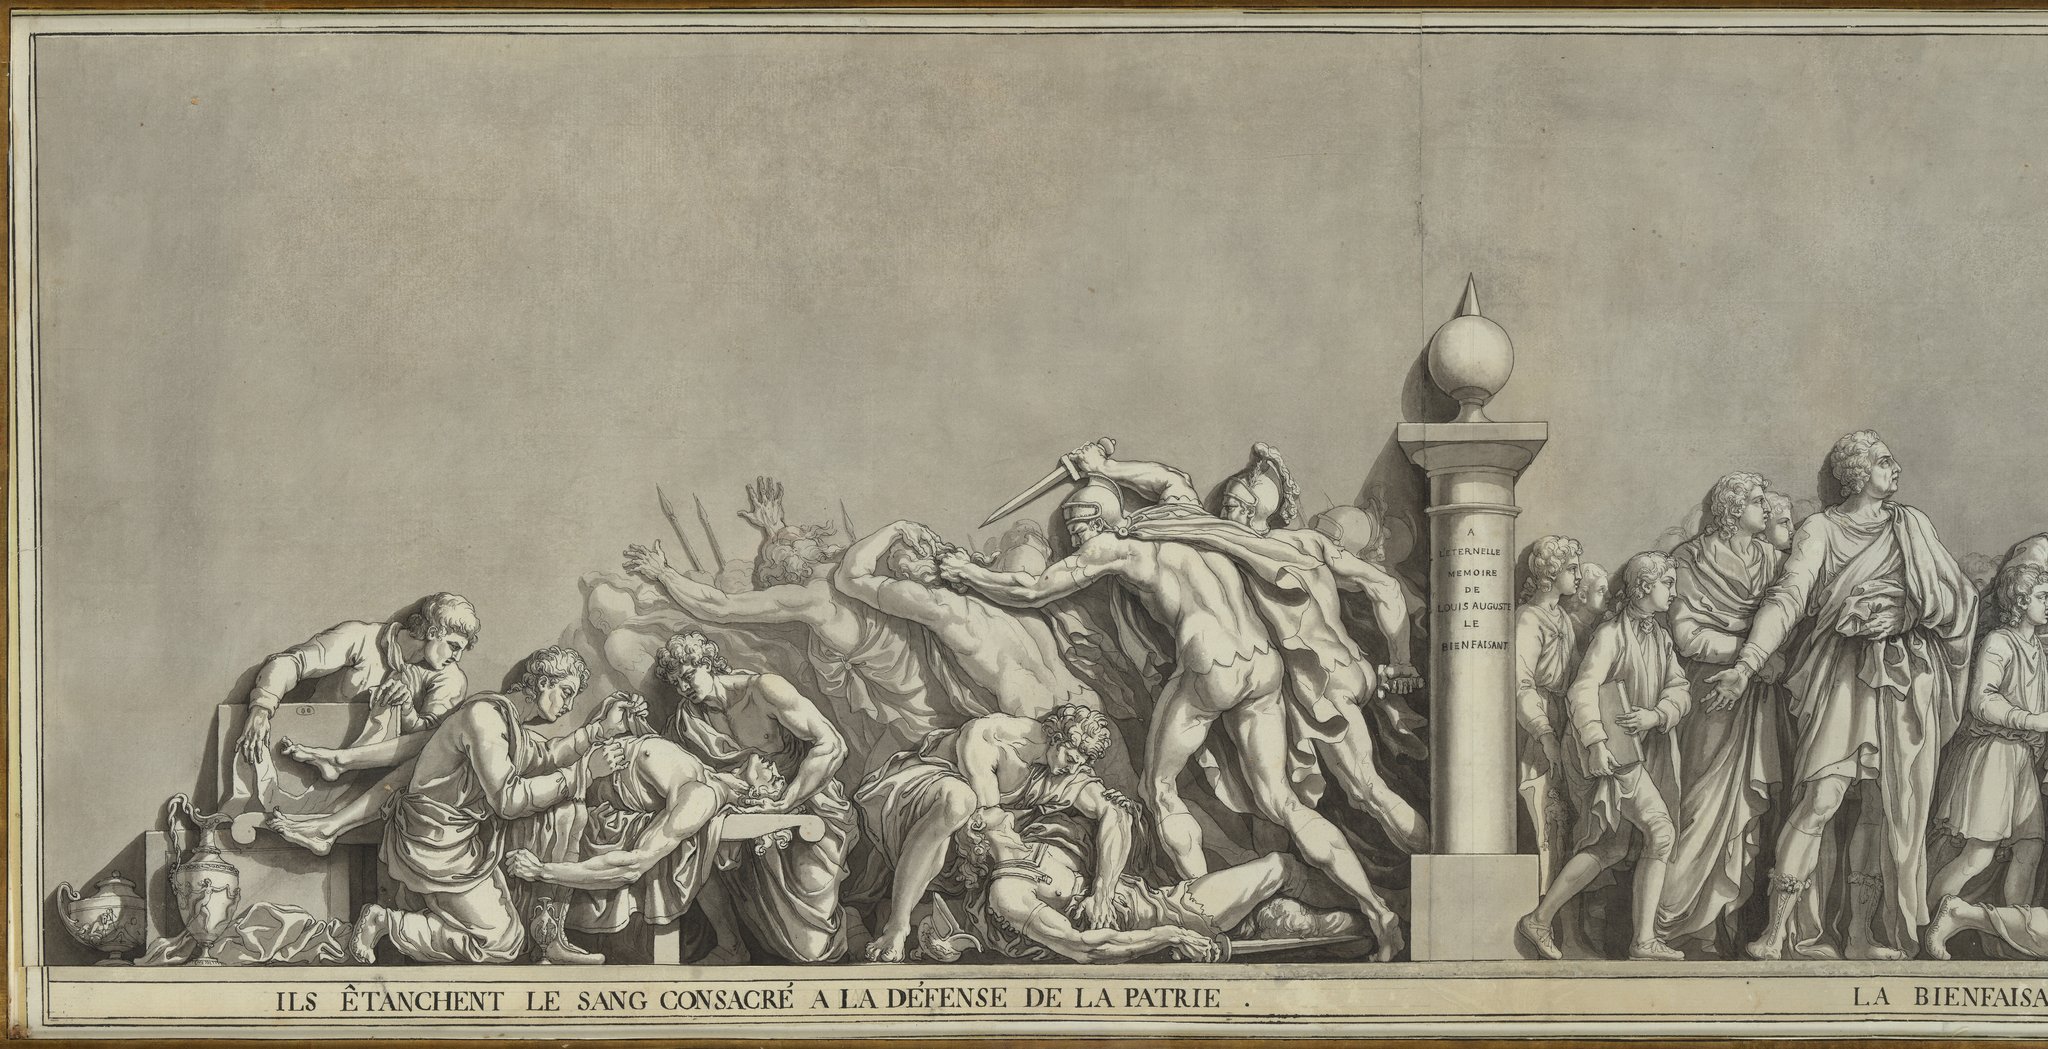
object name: drawing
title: Louis XVI as the Benefactor of Surgery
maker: esprit antoine gibelin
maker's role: artist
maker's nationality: french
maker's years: 1739-1813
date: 1771-1774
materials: chalk, ink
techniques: brush, pen, drawing, wash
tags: louis xvi,medicine,doctors